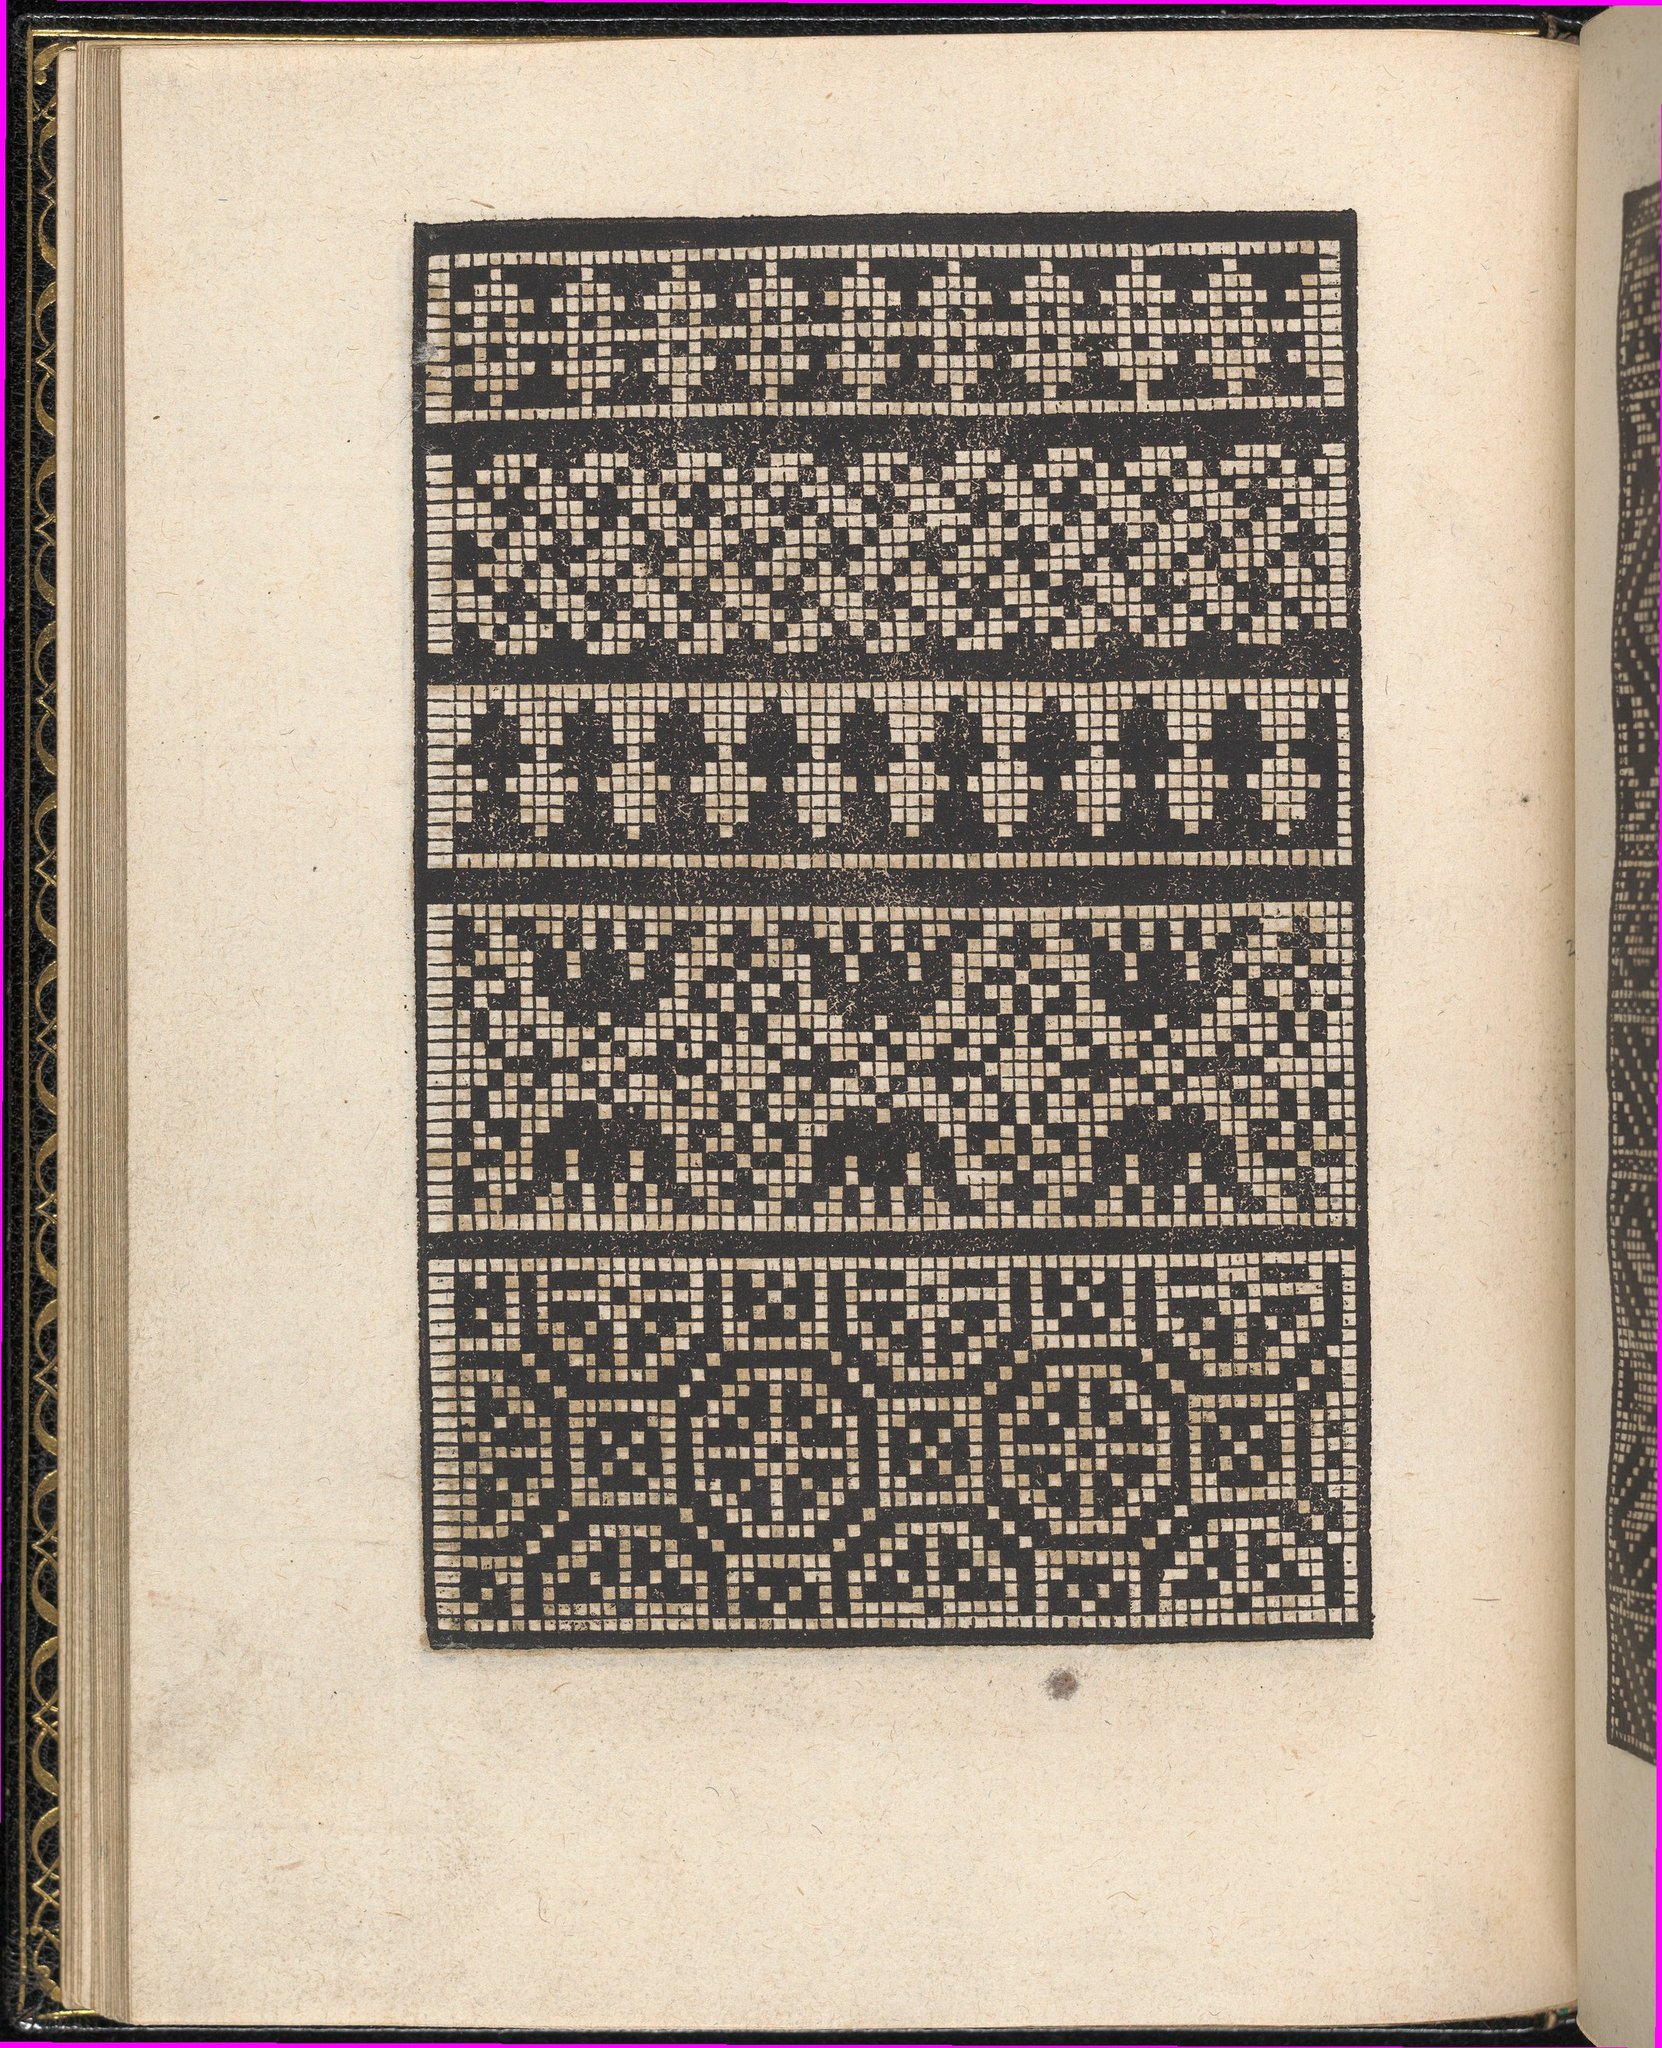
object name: book print ornament architecture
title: Page from Ein new kunstlich Modelbuch...(Page 23v)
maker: peter quentel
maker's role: publisher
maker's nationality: german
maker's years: 1500-1550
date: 1544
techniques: woodcut